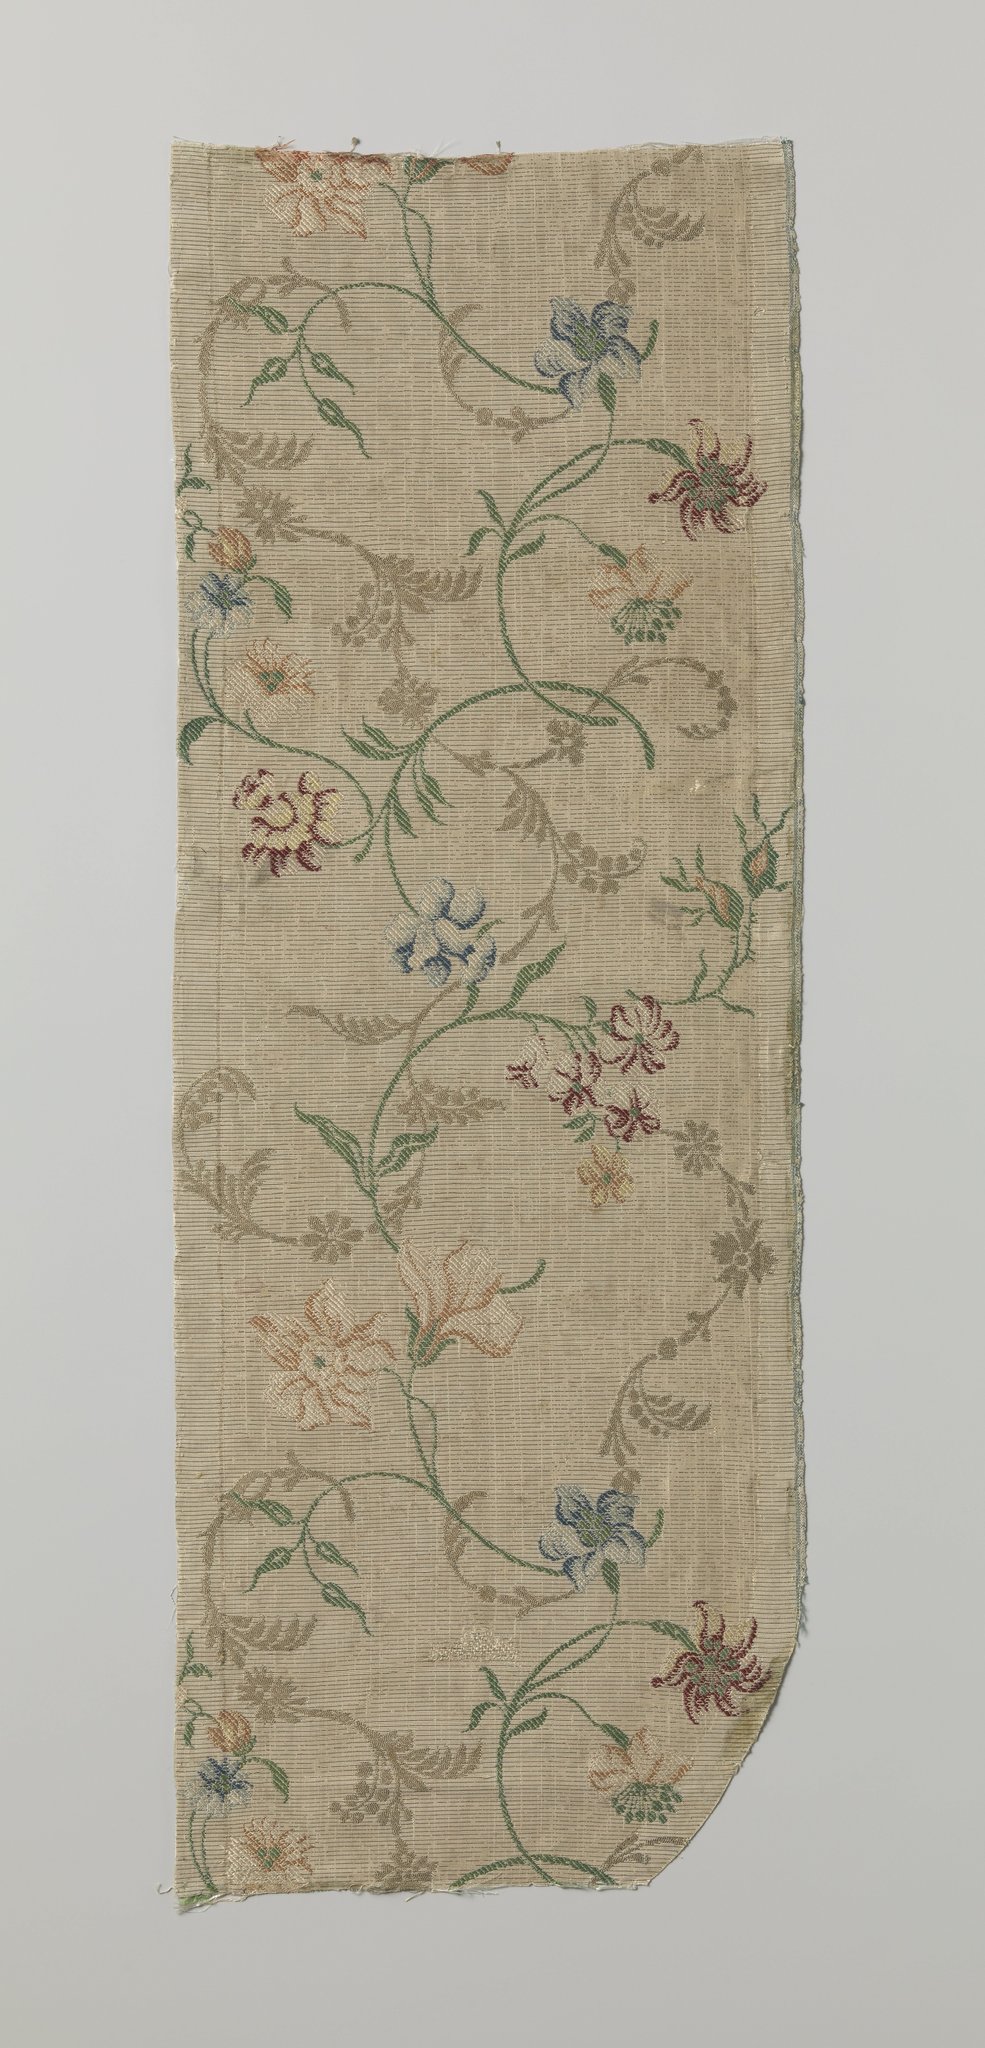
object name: fragment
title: Fragment veelkleurige gebrocheerde zijde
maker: Anonymous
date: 1740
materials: silk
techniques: brocade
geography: england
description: Een zijdeweefsel, bestaande uit twee rechthoekige lappen, groene ranken met diverse bloemen o.a. grote zalmkleurige kelkvormige blauwe, rode en witte rozet bloemen. Opmerking: Twee panelen aan elkaar gezet links en rechts een zelfkant; 0.3 cm effenbinding.